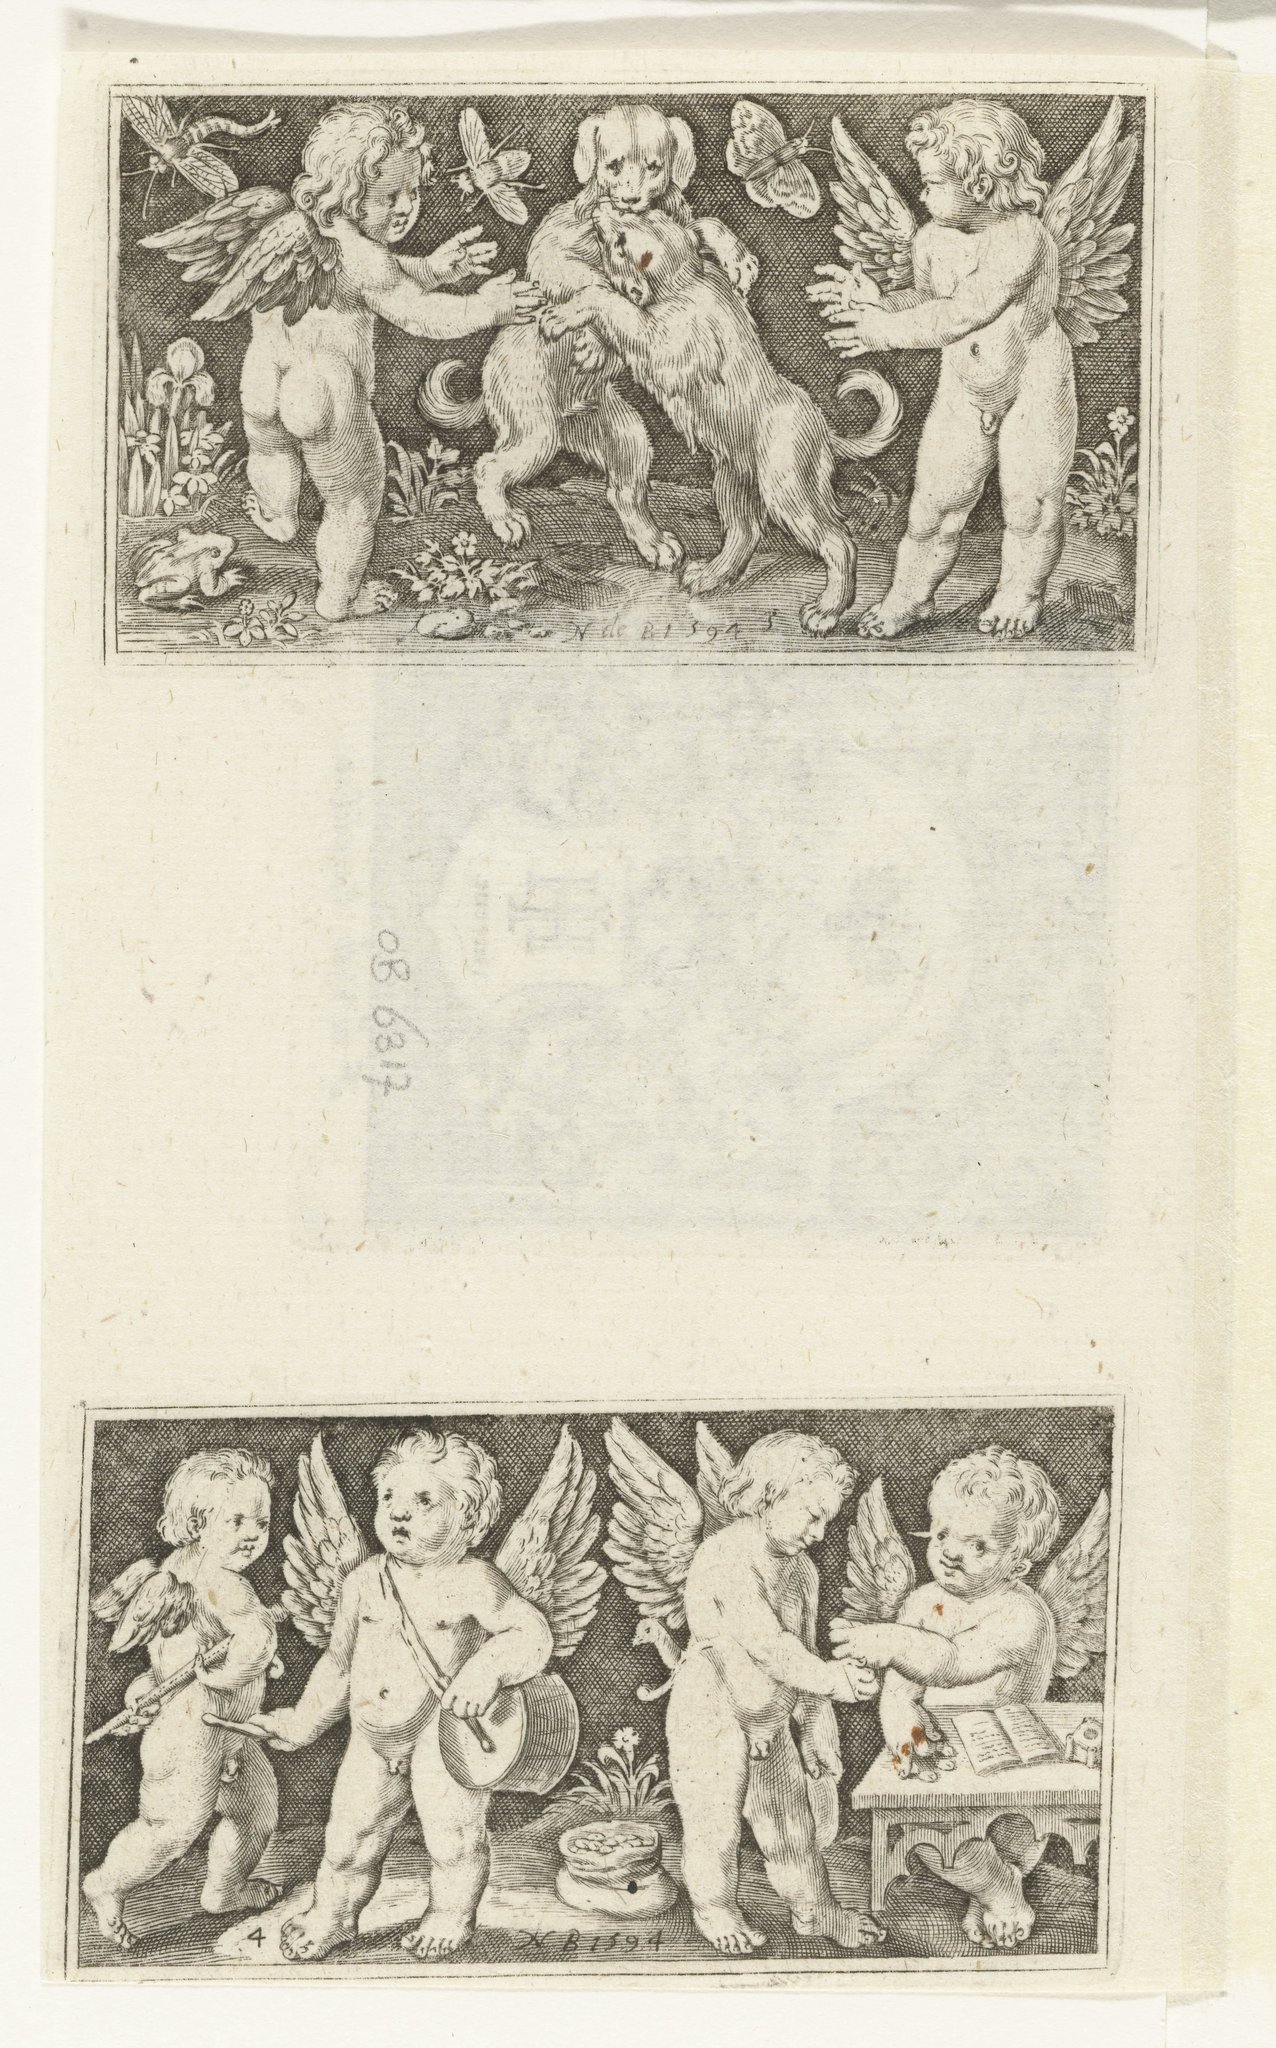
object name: ornament print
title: Twee friezen met cherubijntjes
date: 1617-1700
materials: paper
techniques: engraving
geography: amsterdam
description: In het bovenste fries staan twee cherubijntjes naast twee honden. In het onderste zijn vier cherubijntjes te zien, waarvan de linker twee met muziekinstrumenten.